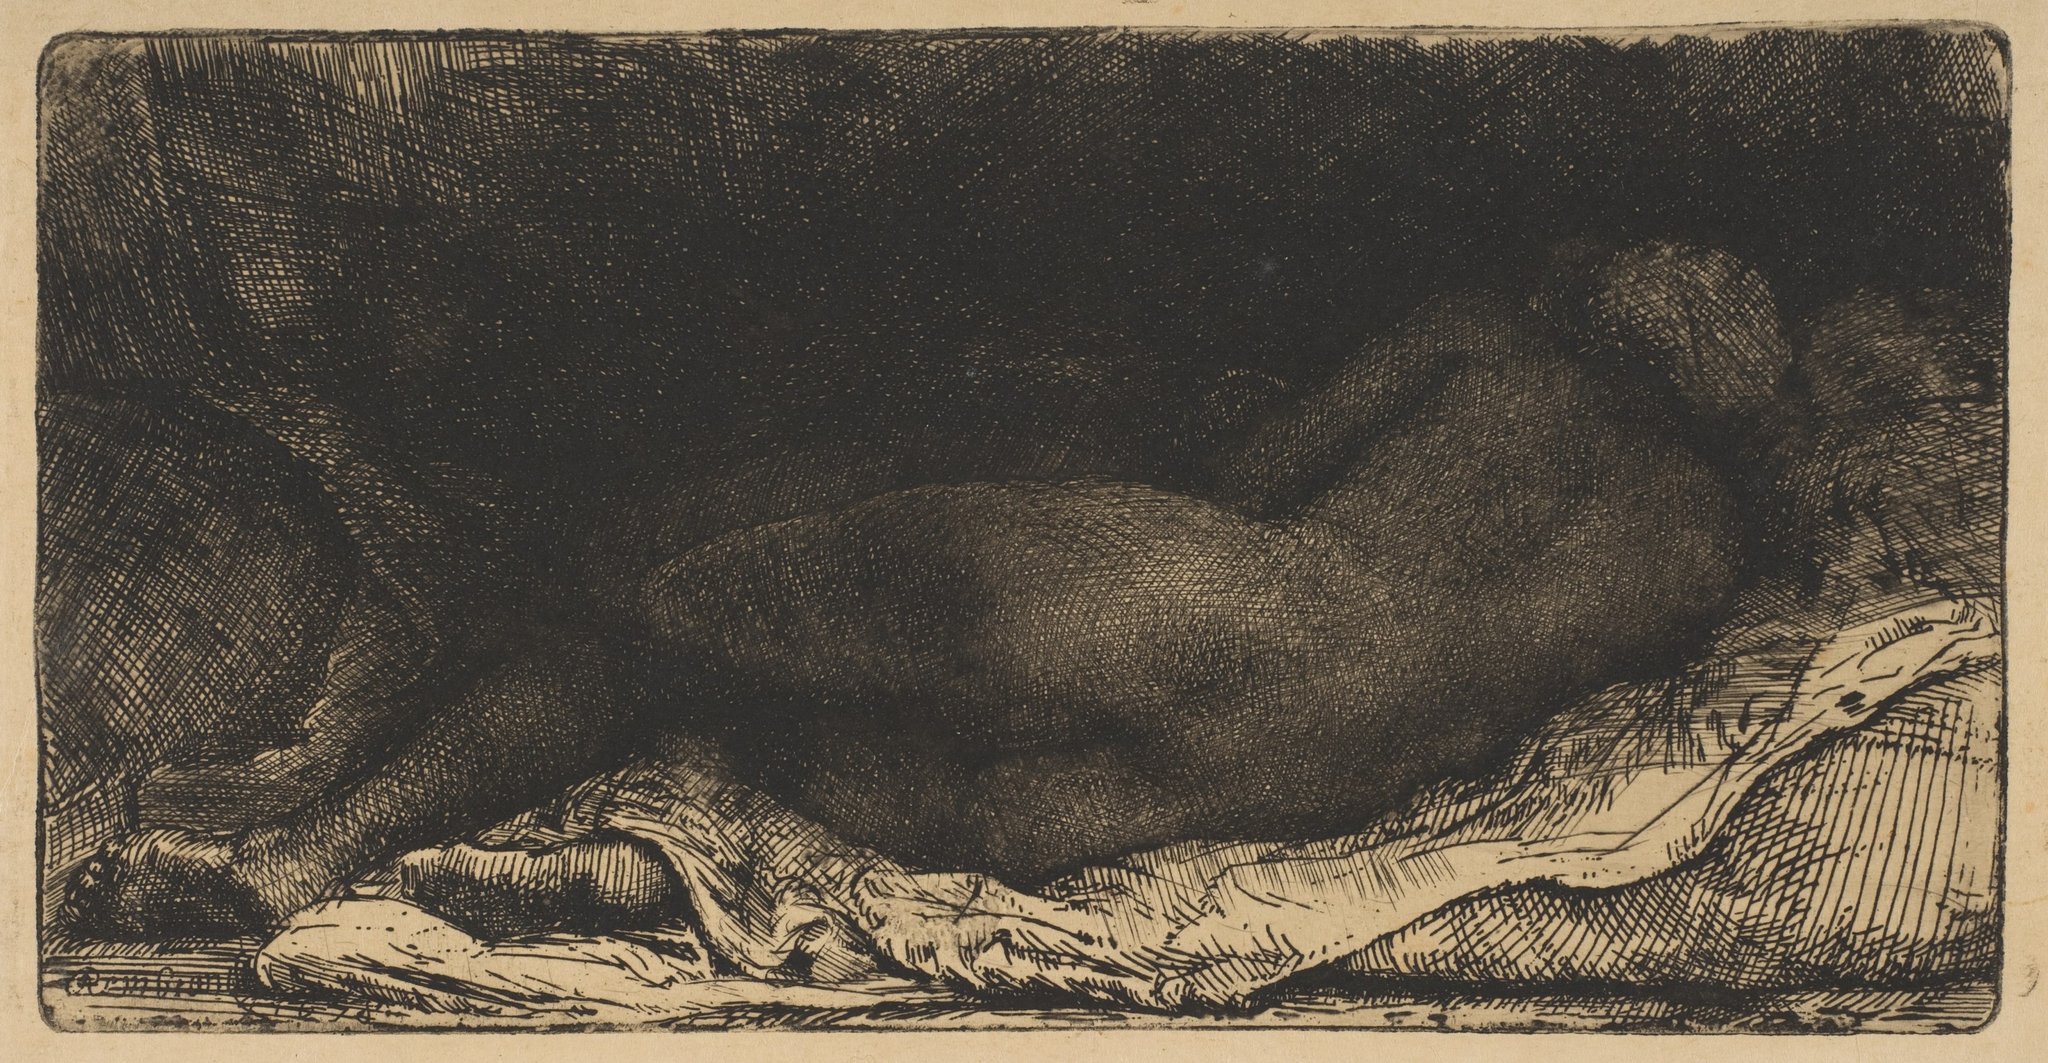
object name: print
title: Reclining Female Nude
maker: rembrandt van rijn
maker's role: artist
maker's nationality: dutch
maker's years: 1606-1669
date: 1658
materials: paper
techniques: drypoint, engraving, etching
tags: female nudes